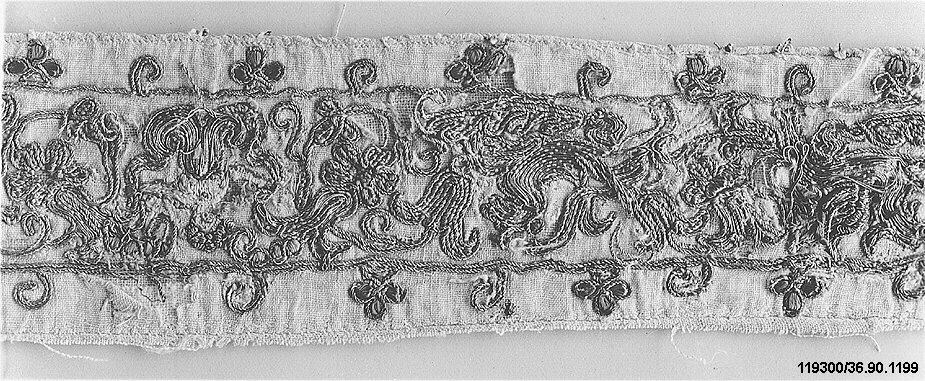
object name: band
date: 1501-1600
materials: linen, metal thread, silk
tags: flowers